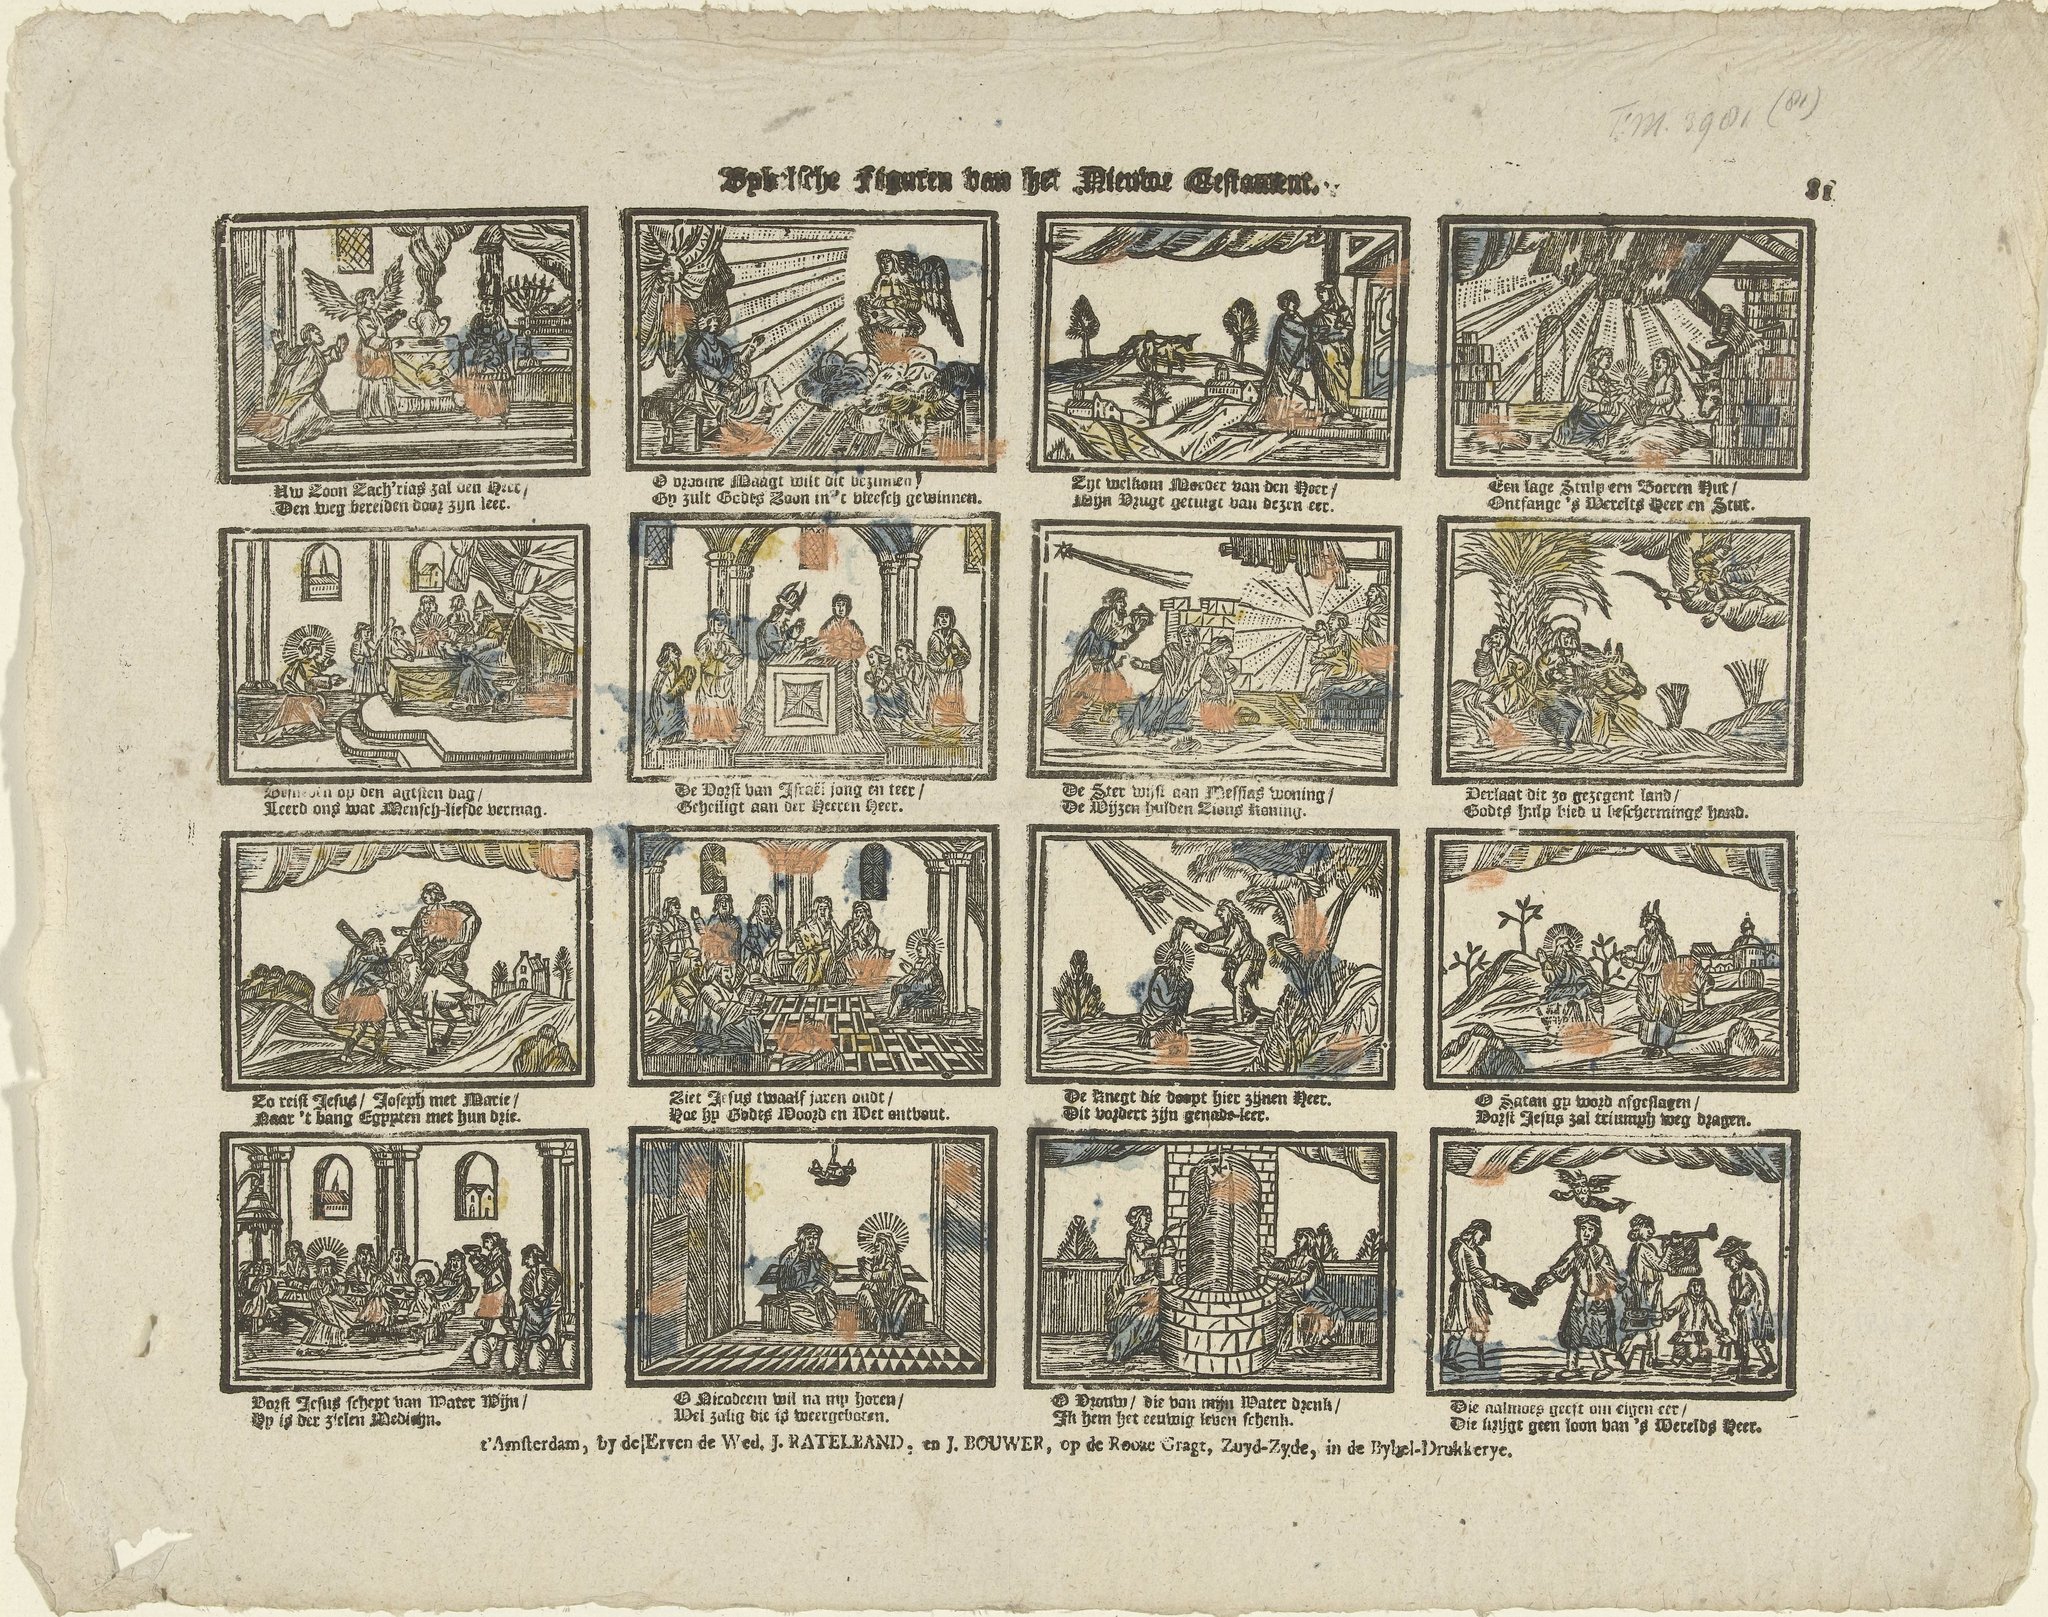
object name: print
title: Bybelsche figuren van het Nieuwe Testament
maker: Anonymous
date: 1782-1793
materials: paper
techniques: colour, letterpress printing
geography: amsterdam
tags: new testament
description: Blad met 16 voorstellingen van verhalen uit het Nieuwe Testament. Onder elke afbeelding een tweeregelig vers. Genummerd rechtsboven: 81.